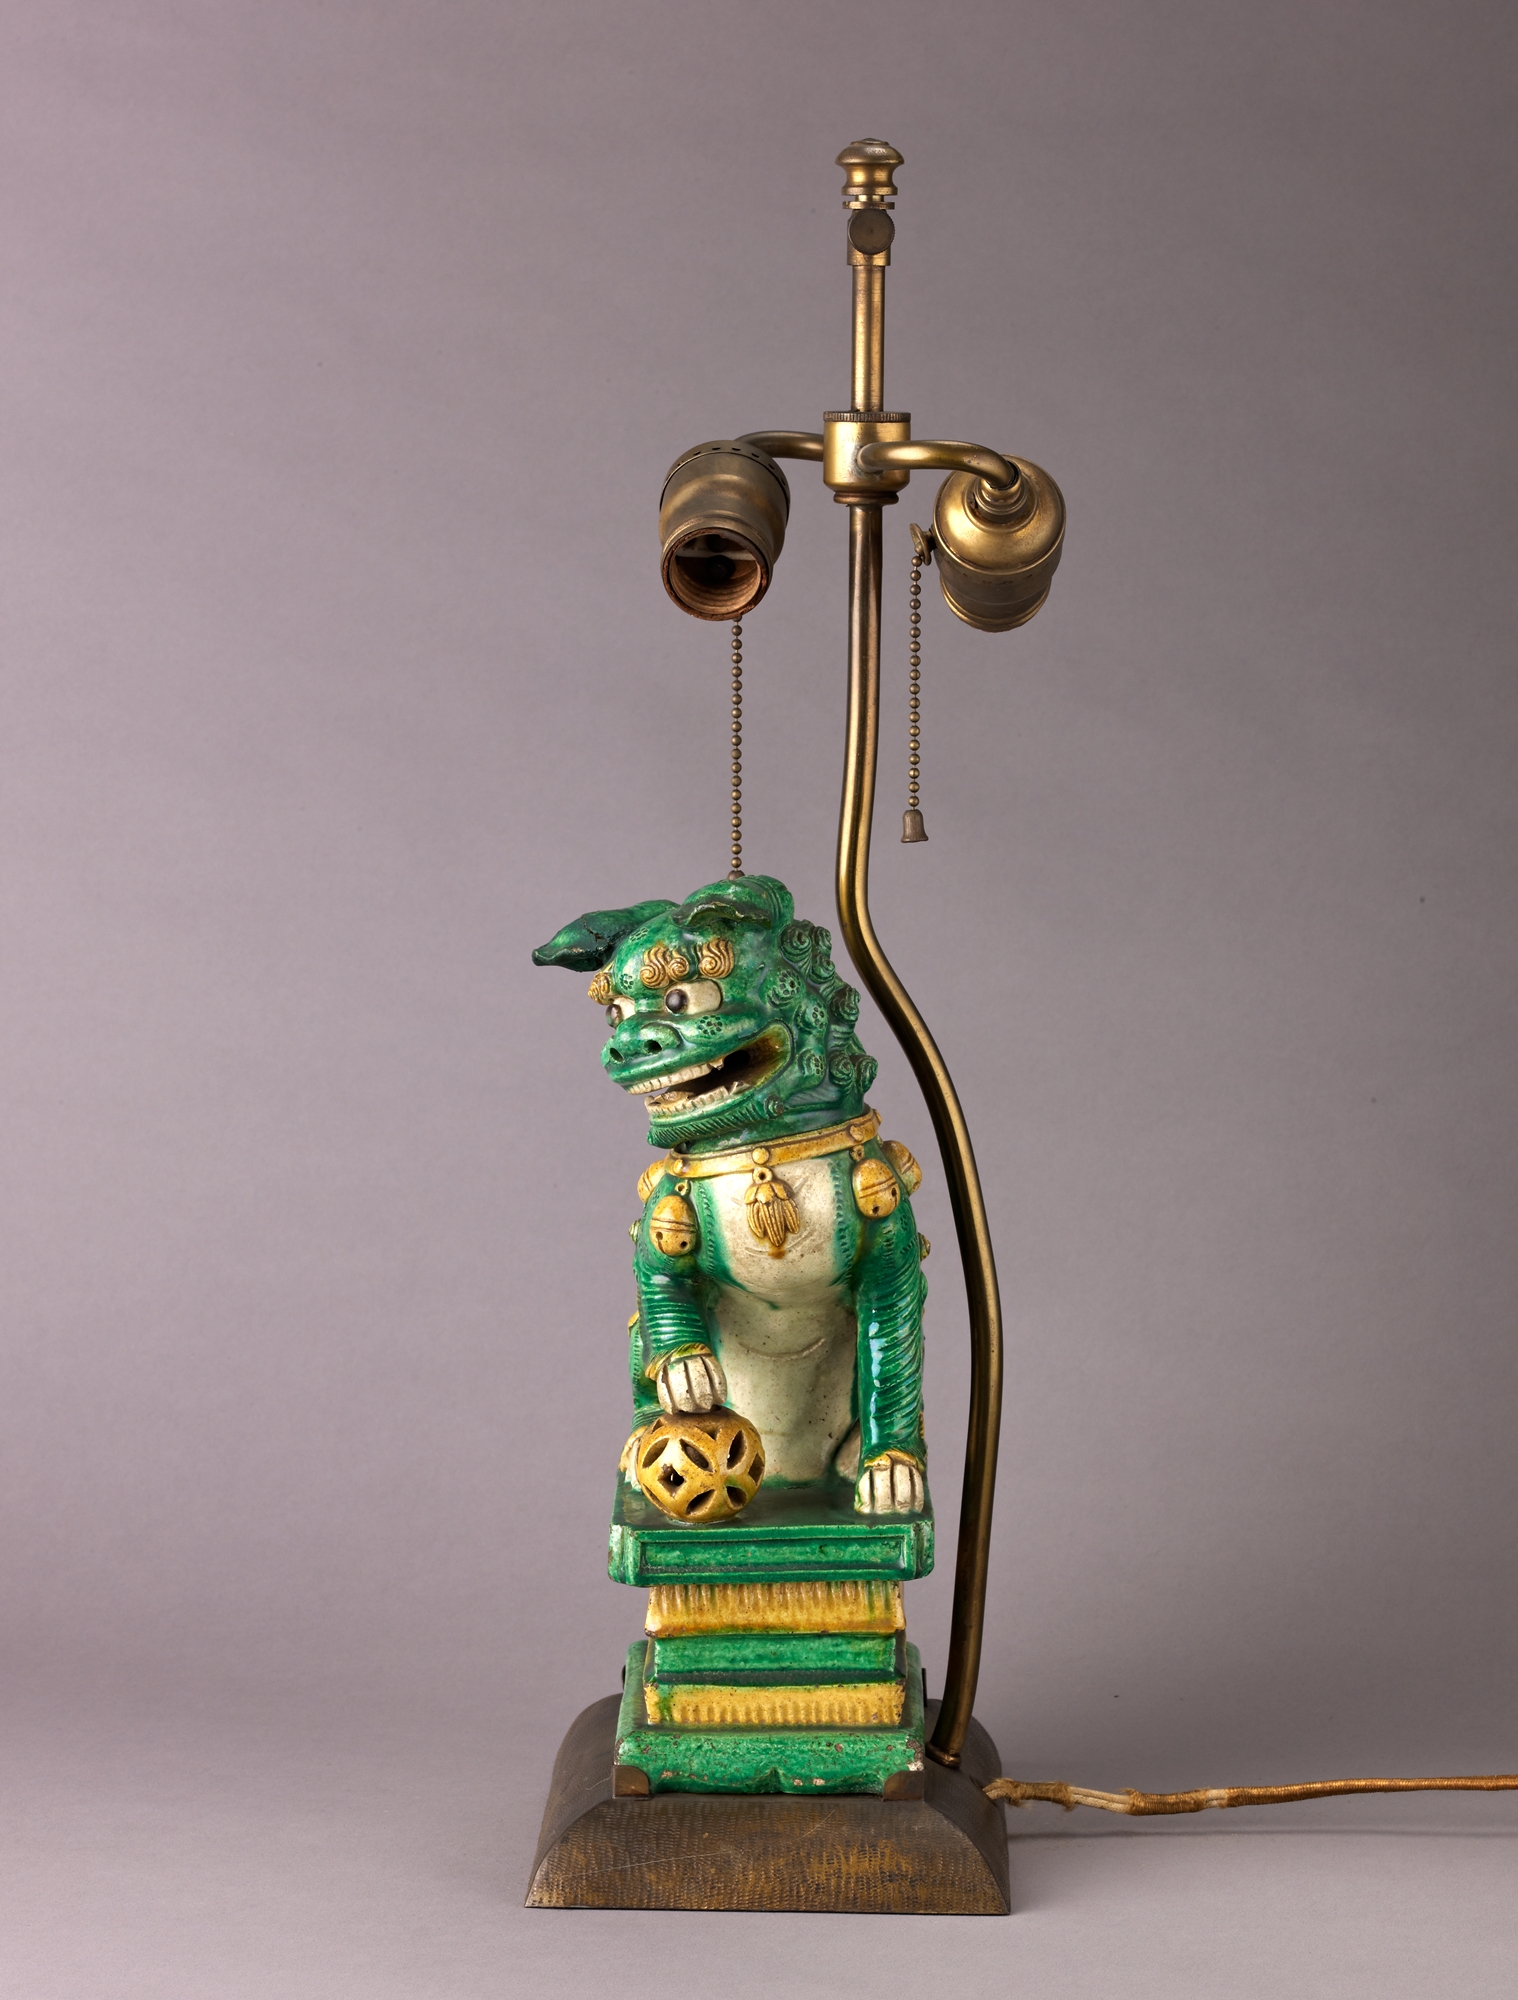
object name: lion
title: Figure of lion mounted as lamp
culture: chinese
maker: chinese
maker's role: artist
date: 1801-1900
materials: glaze, porcelain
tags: lions